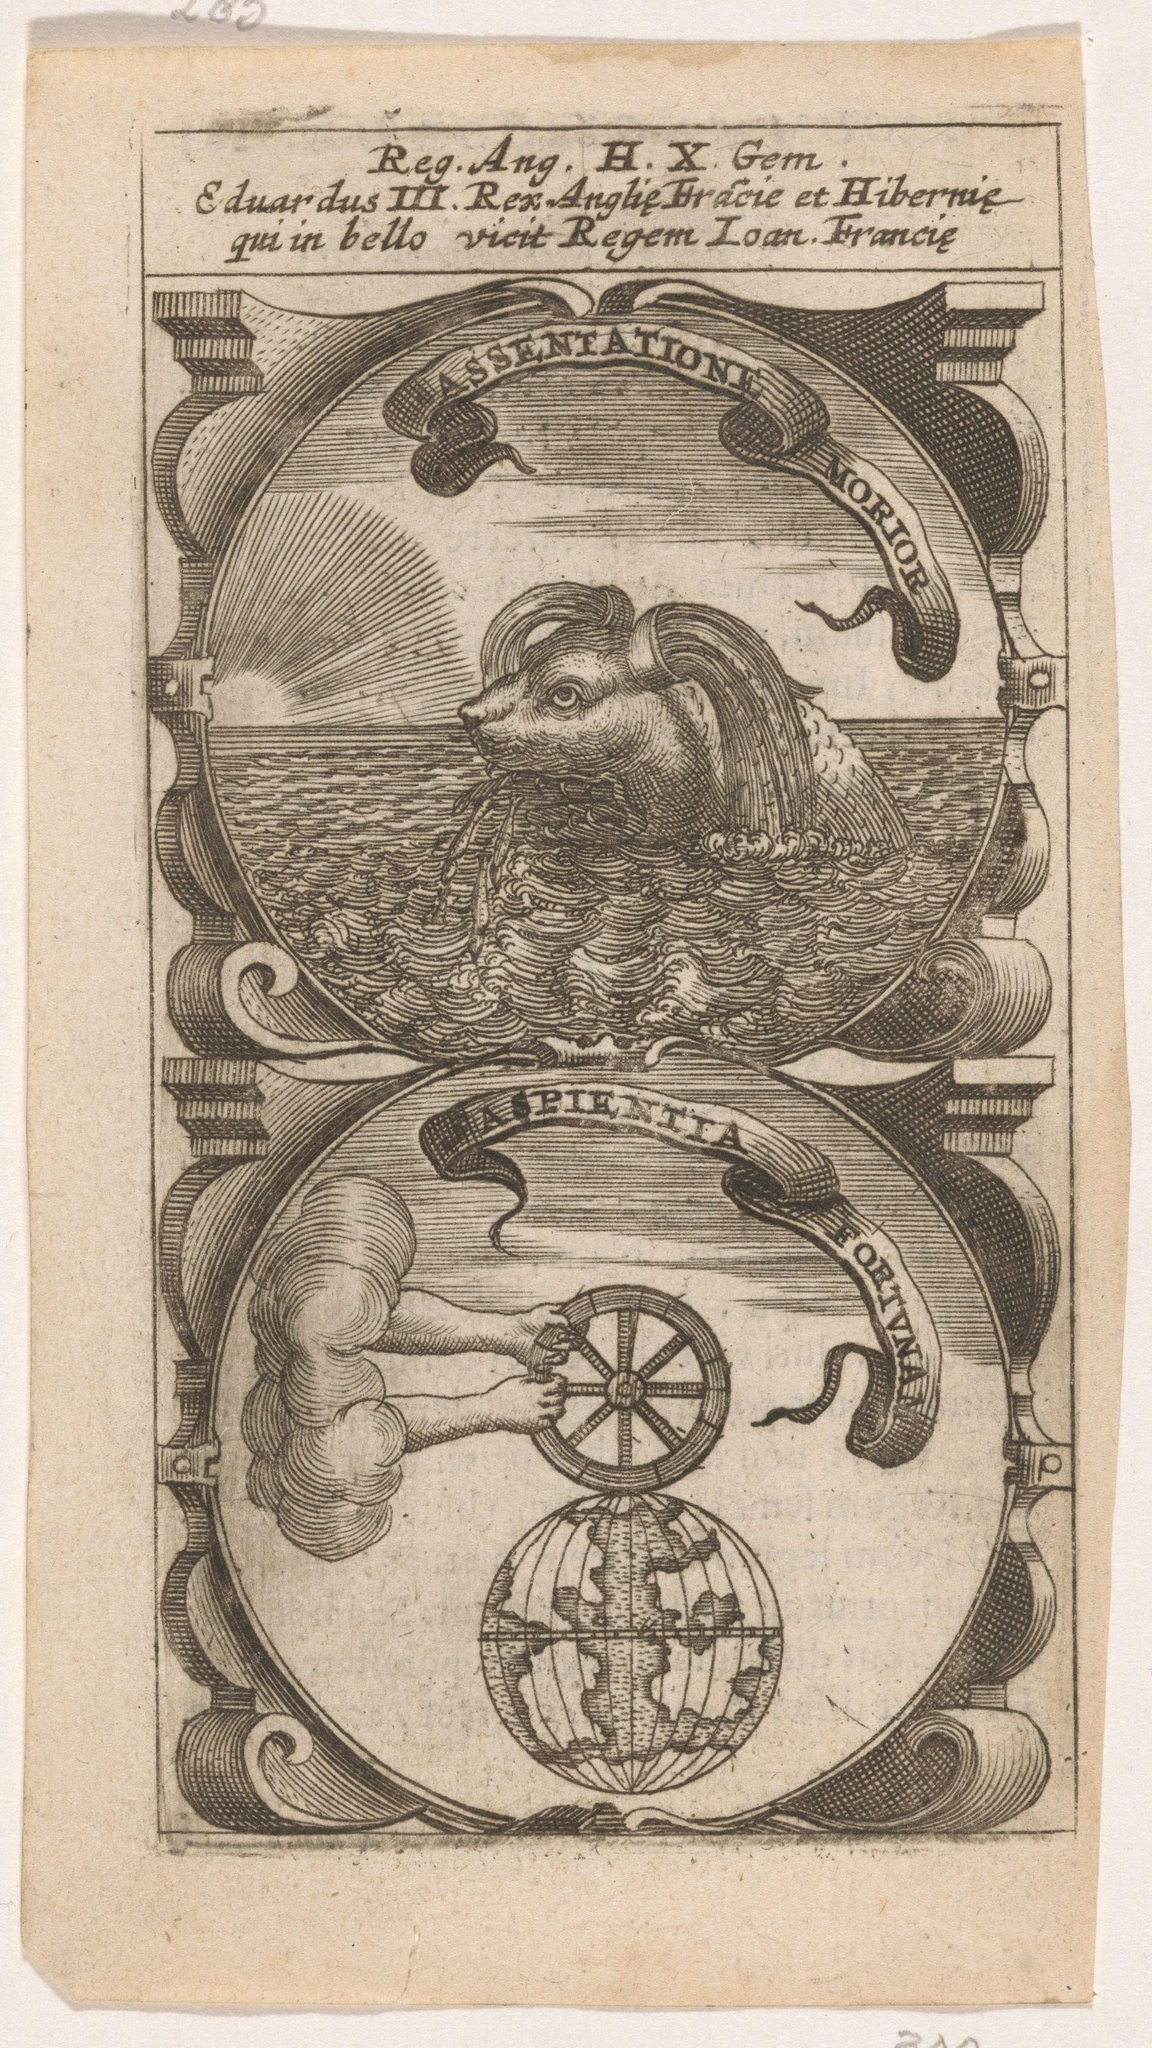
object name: book illustration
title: Assentiatione Morior / Sapientia Fortuna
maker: Anonymous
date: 1666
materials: paper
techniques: engraving, letterpress printing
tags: earth, world as celestial body, turn of fate, wheel of fortune, postures and gestures of arms and hands, swimming mammals: dolphin - ff - fabulous animals (sometimes wrongly called 'grotesques'); 'mostri' (ripa)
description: Een embleem met twee voorstellingen. Boven een dolfijn of monster in het water bij opkomende zon. Uit zijn bek komen vissen. Onder een wereldbol. Het rad bovenop de wereld wordt vastgehouden door twee handen in de wolken. Het betreffen deviezen van Eduard III van Engeland.